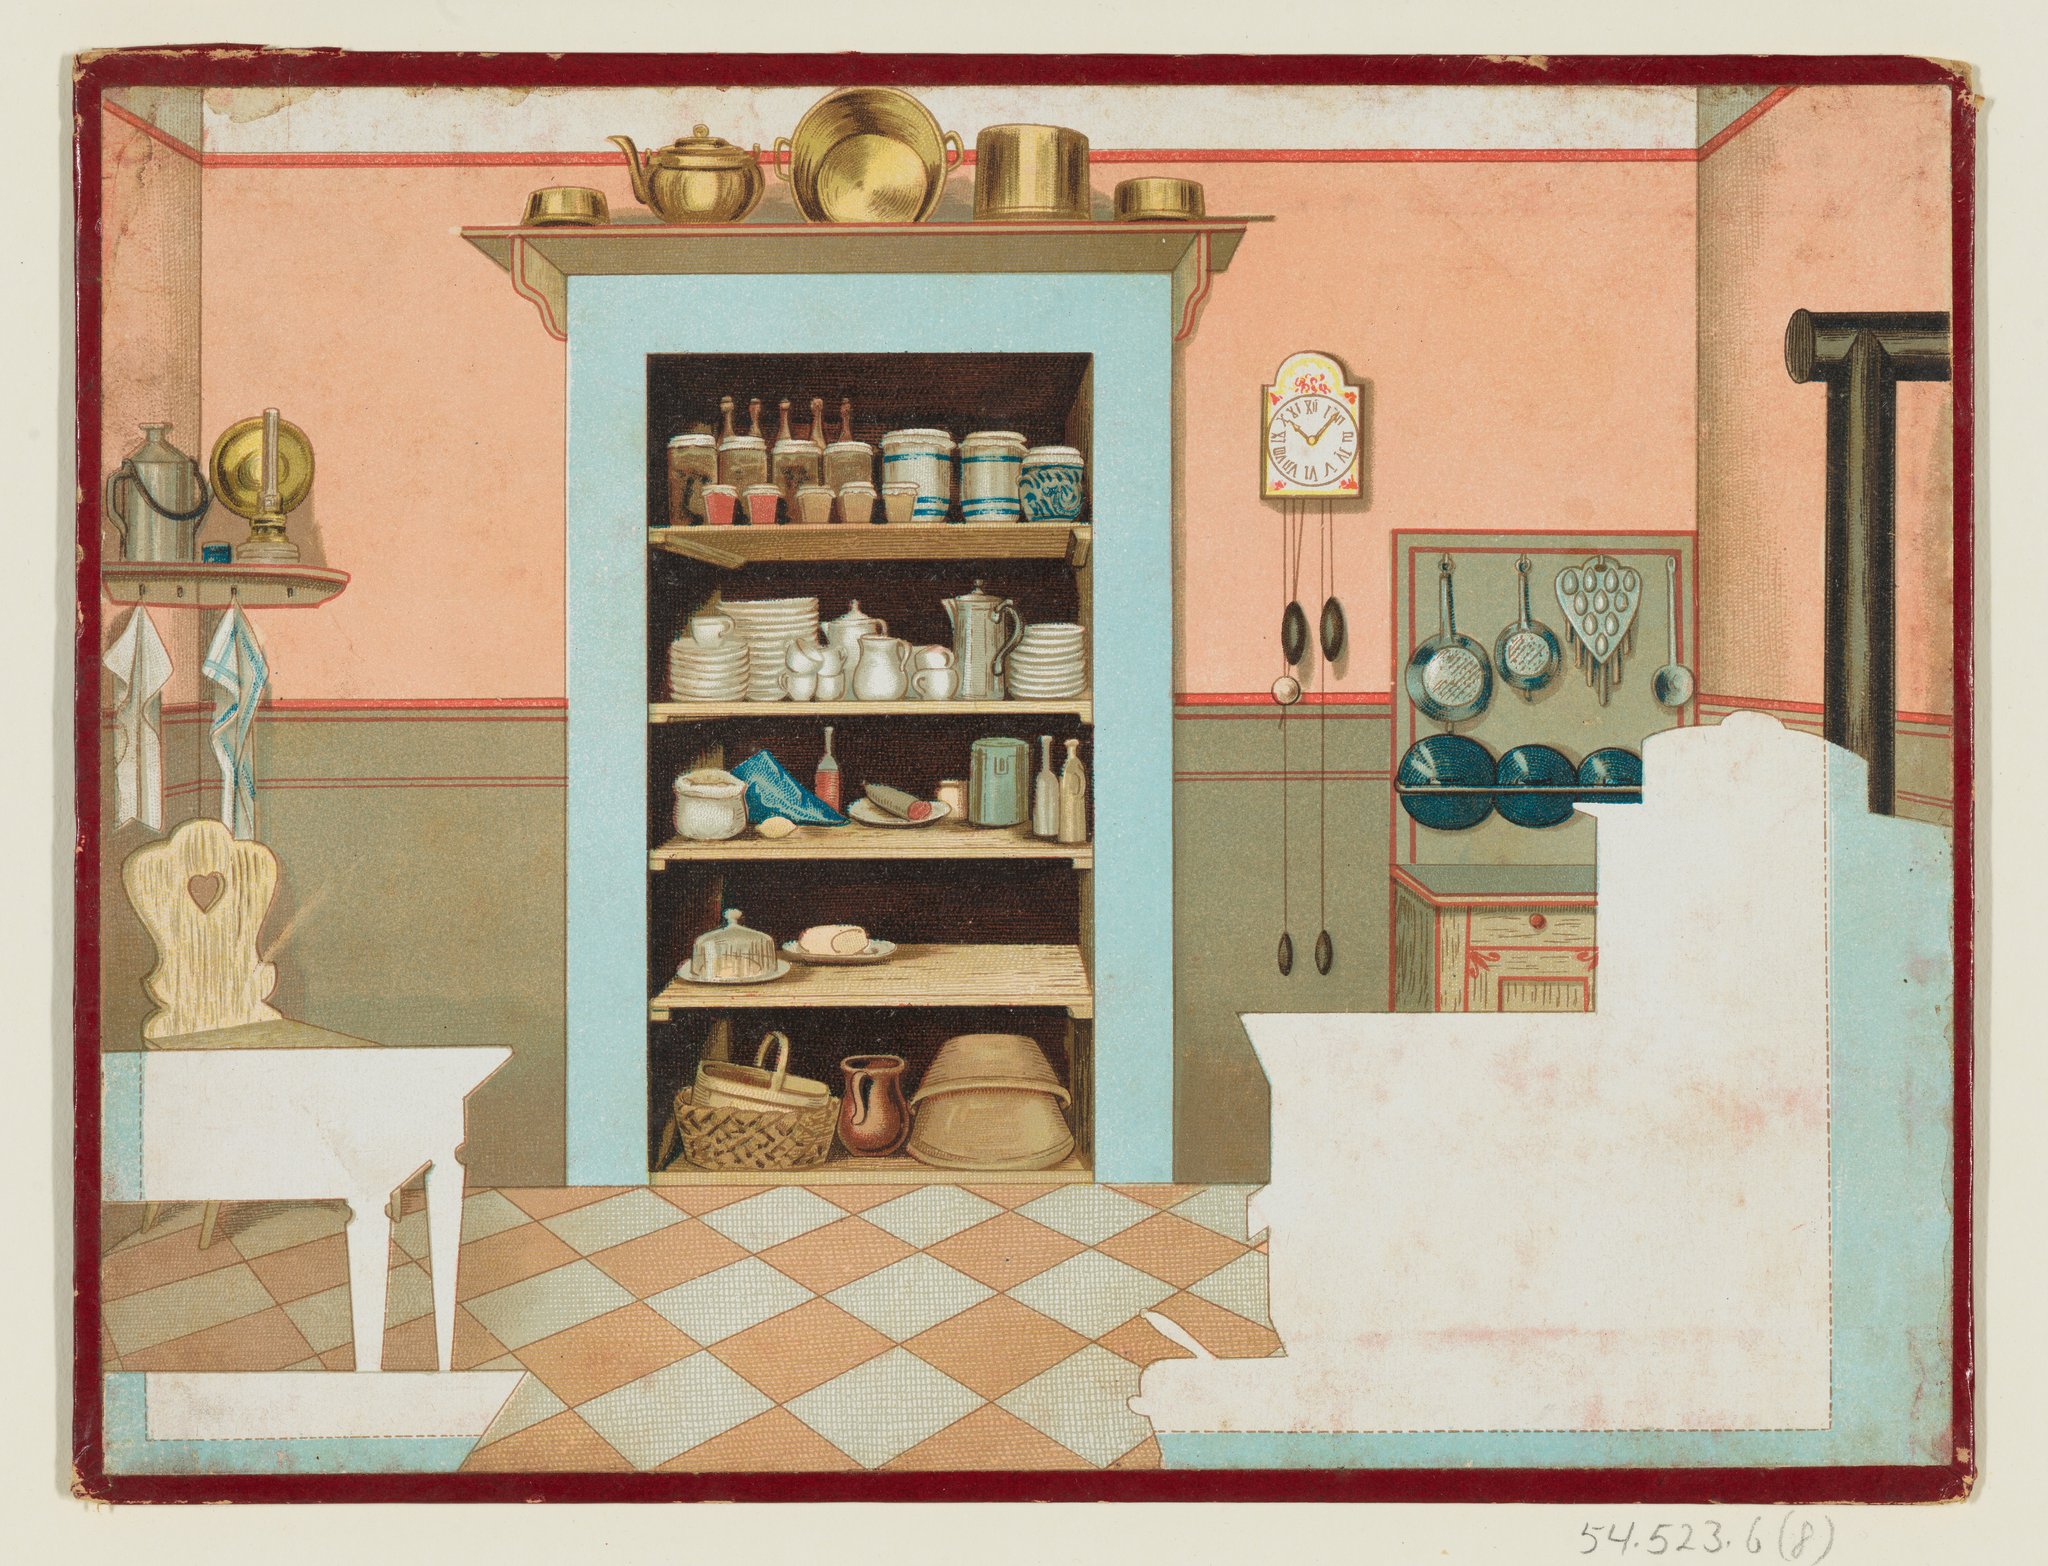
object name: paper doll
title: Kitchen Background, from Dolly at Home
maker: anonymous, german, 19th century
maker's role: artist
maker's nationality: german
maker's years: 1800-1899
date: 1870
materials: cardboard, paper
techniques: lithograph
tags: interiors,kitchens